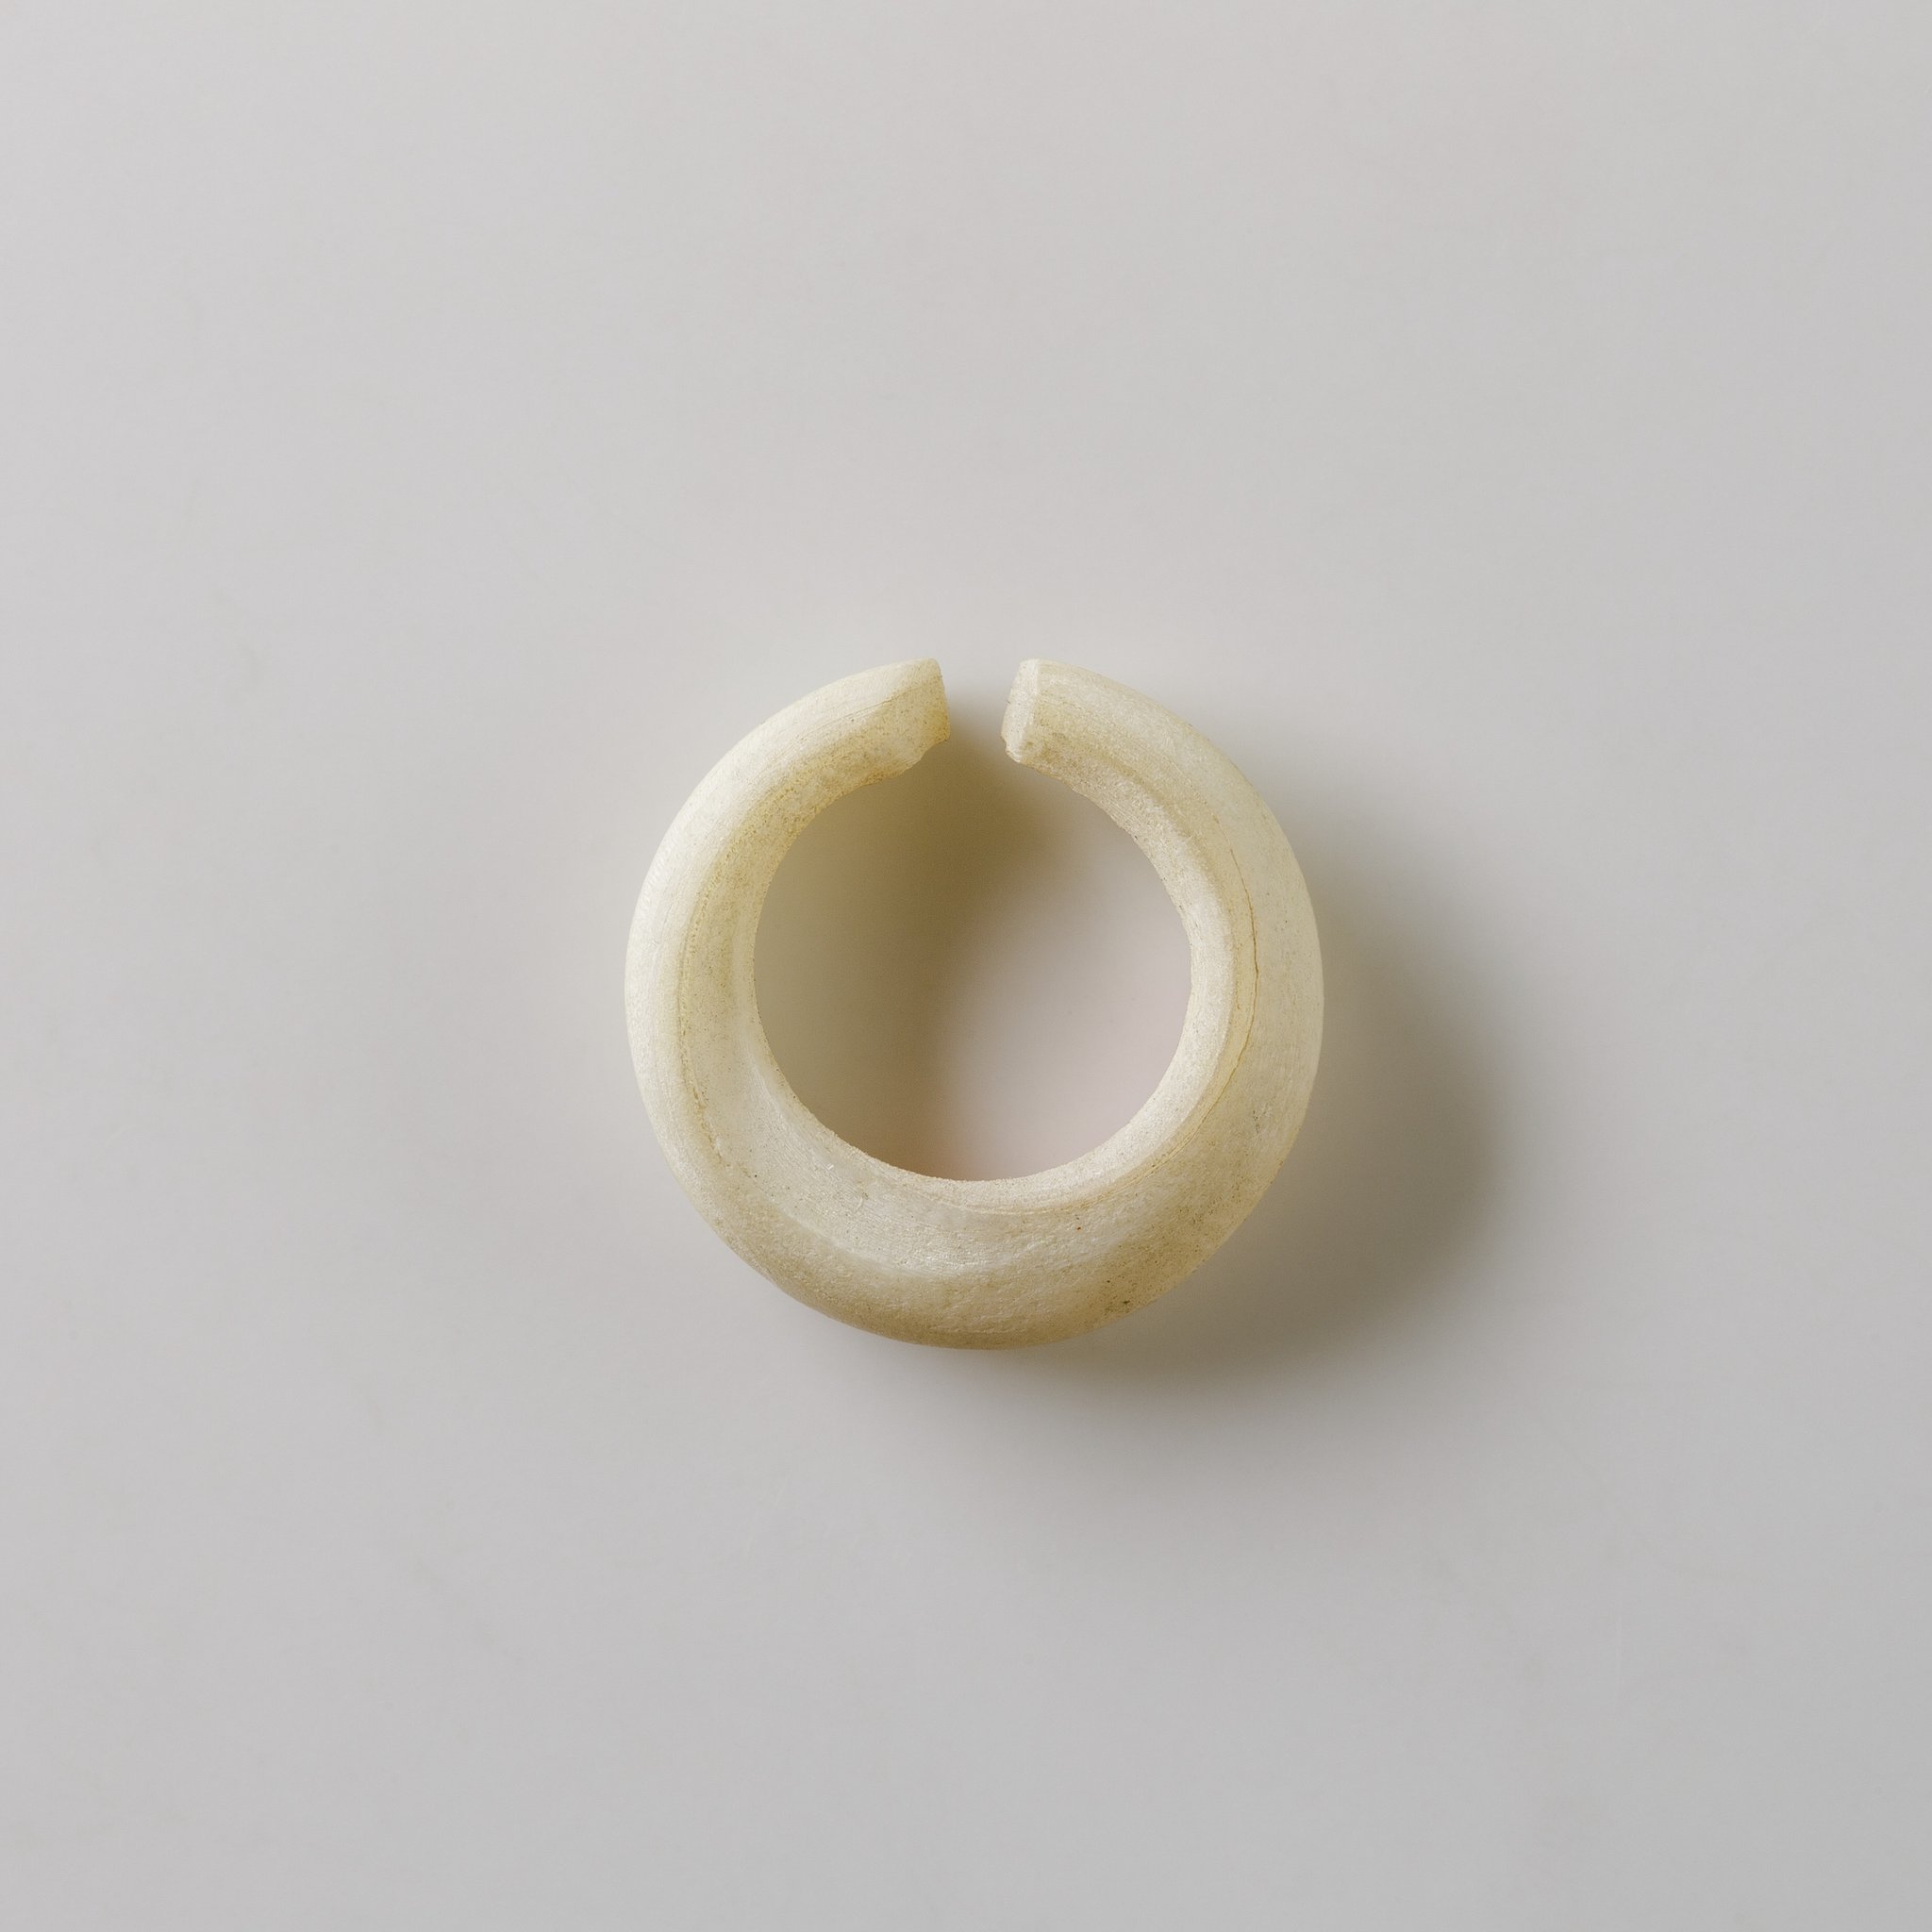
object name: hair ring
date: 1070-343 BCE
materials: shell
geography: egypt